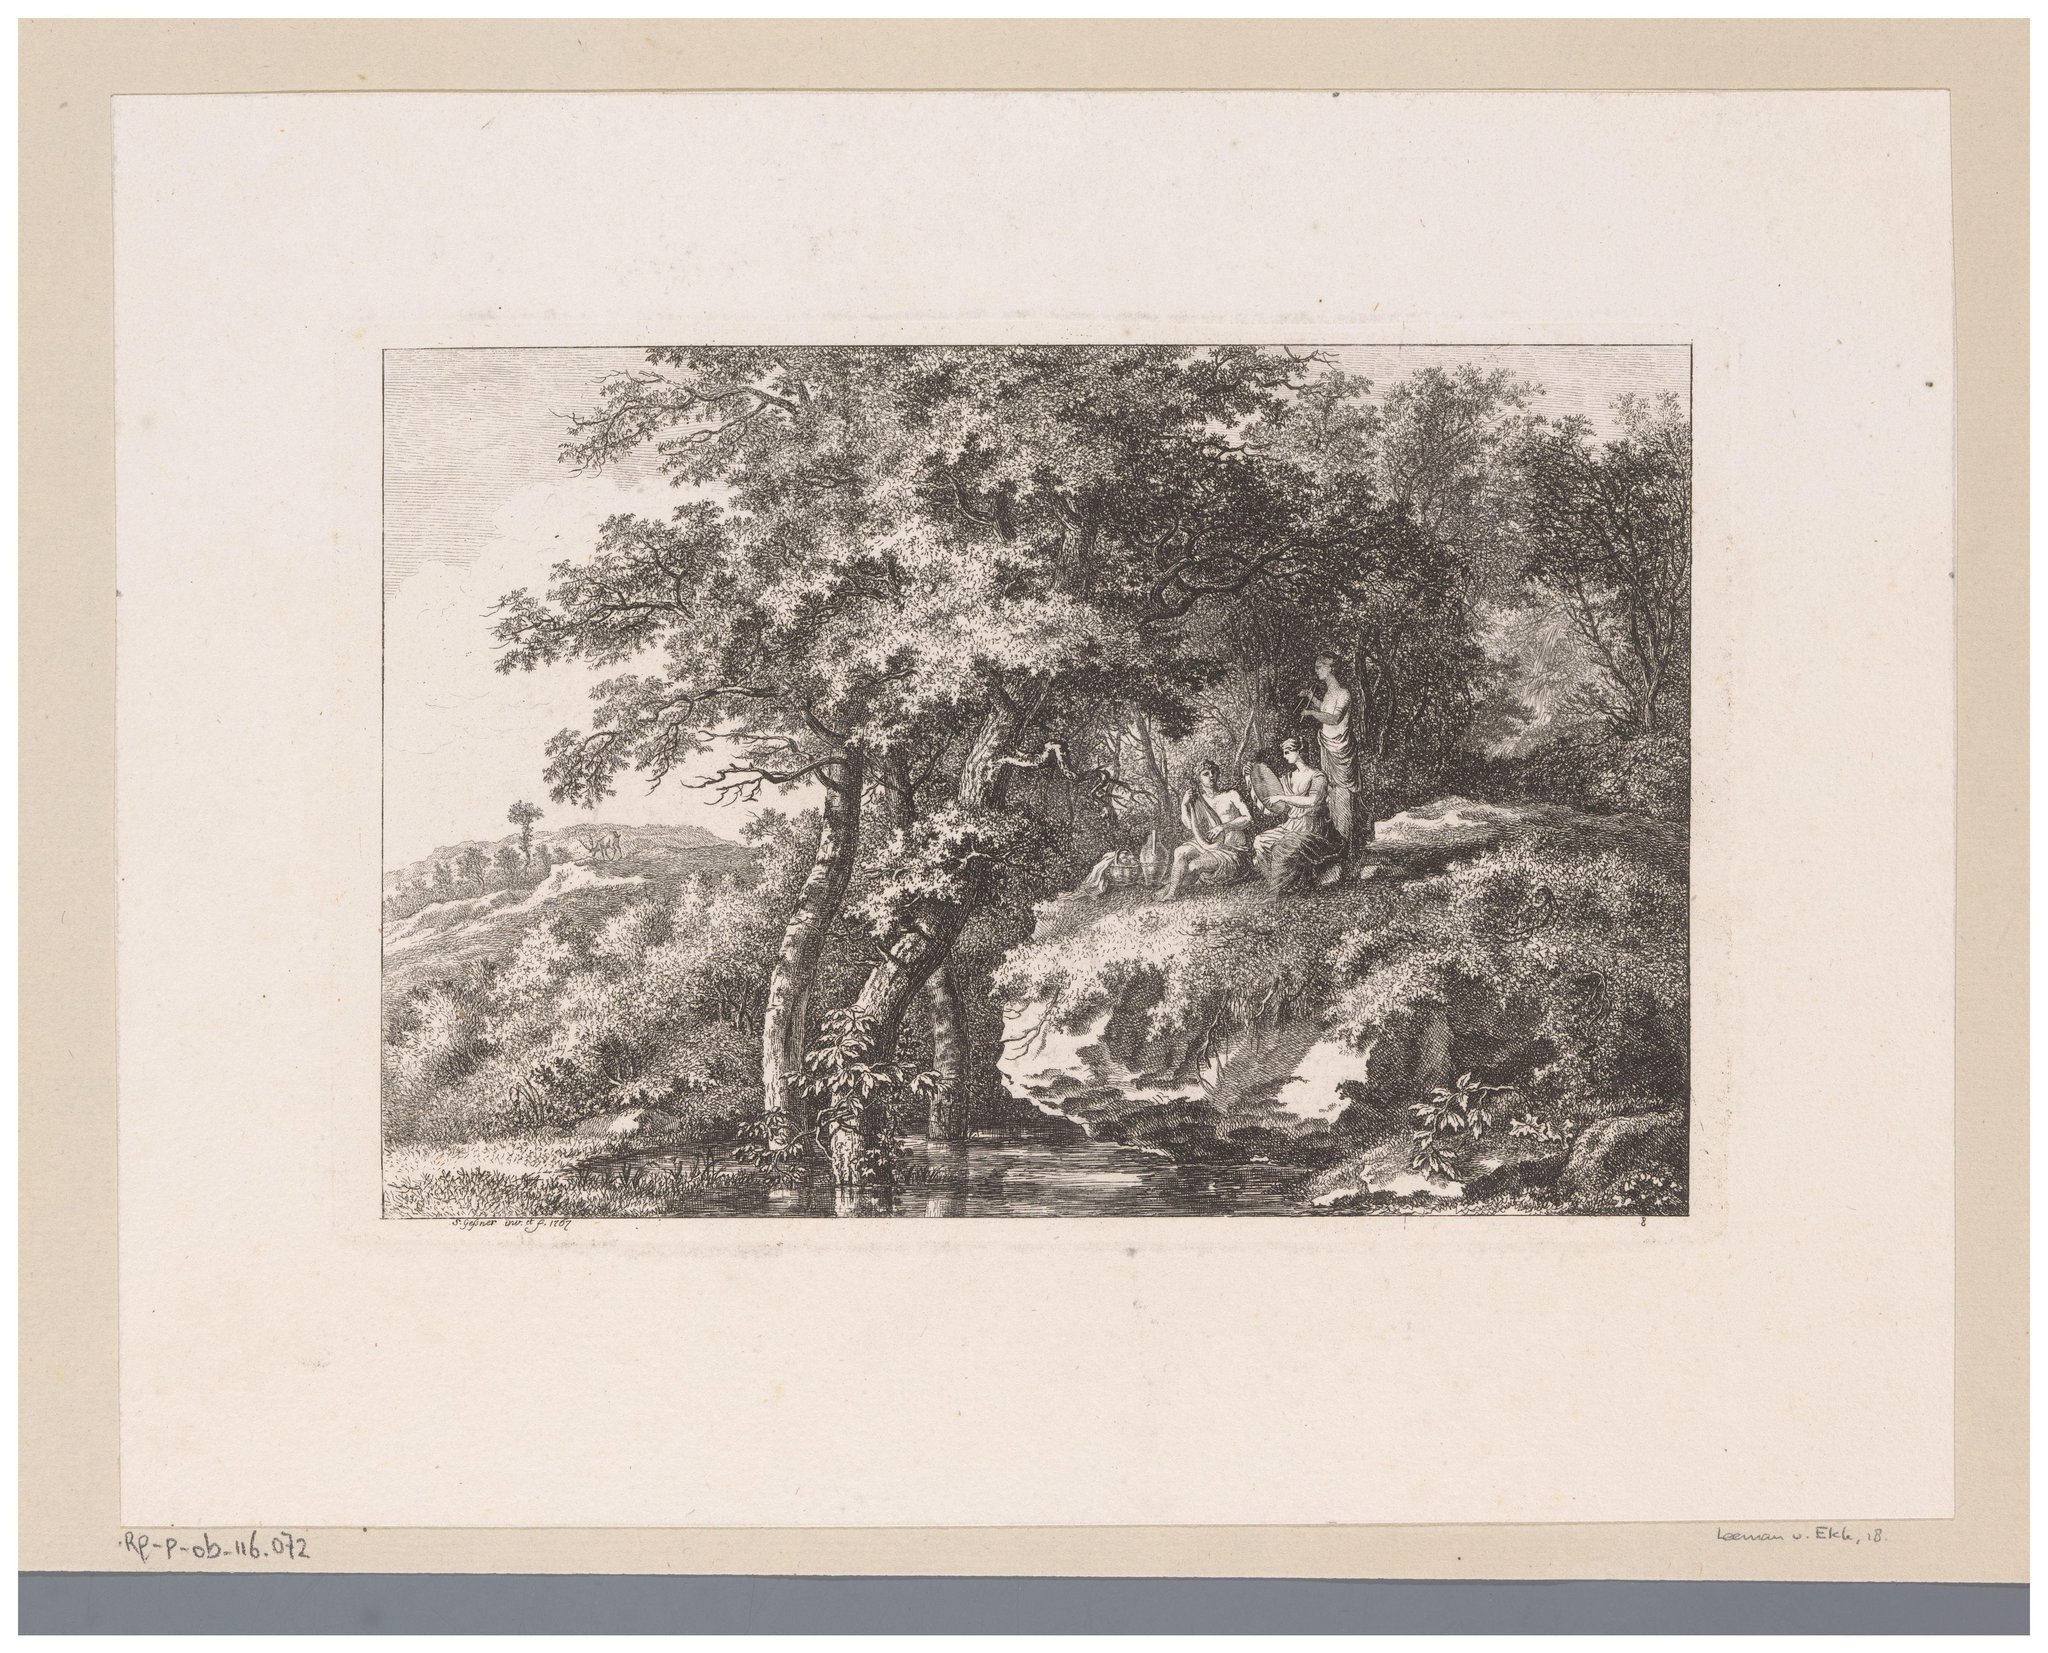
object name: print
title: Musicerend trio in een arcadisch landschap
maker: salomon gessner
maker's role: painter, print maker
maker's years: 1730-1788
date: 1767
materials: paper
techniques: etching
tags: rock-formations - hh - ideal landscapes, more than one musician with instrument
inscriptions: collector's mark: Lugt 240